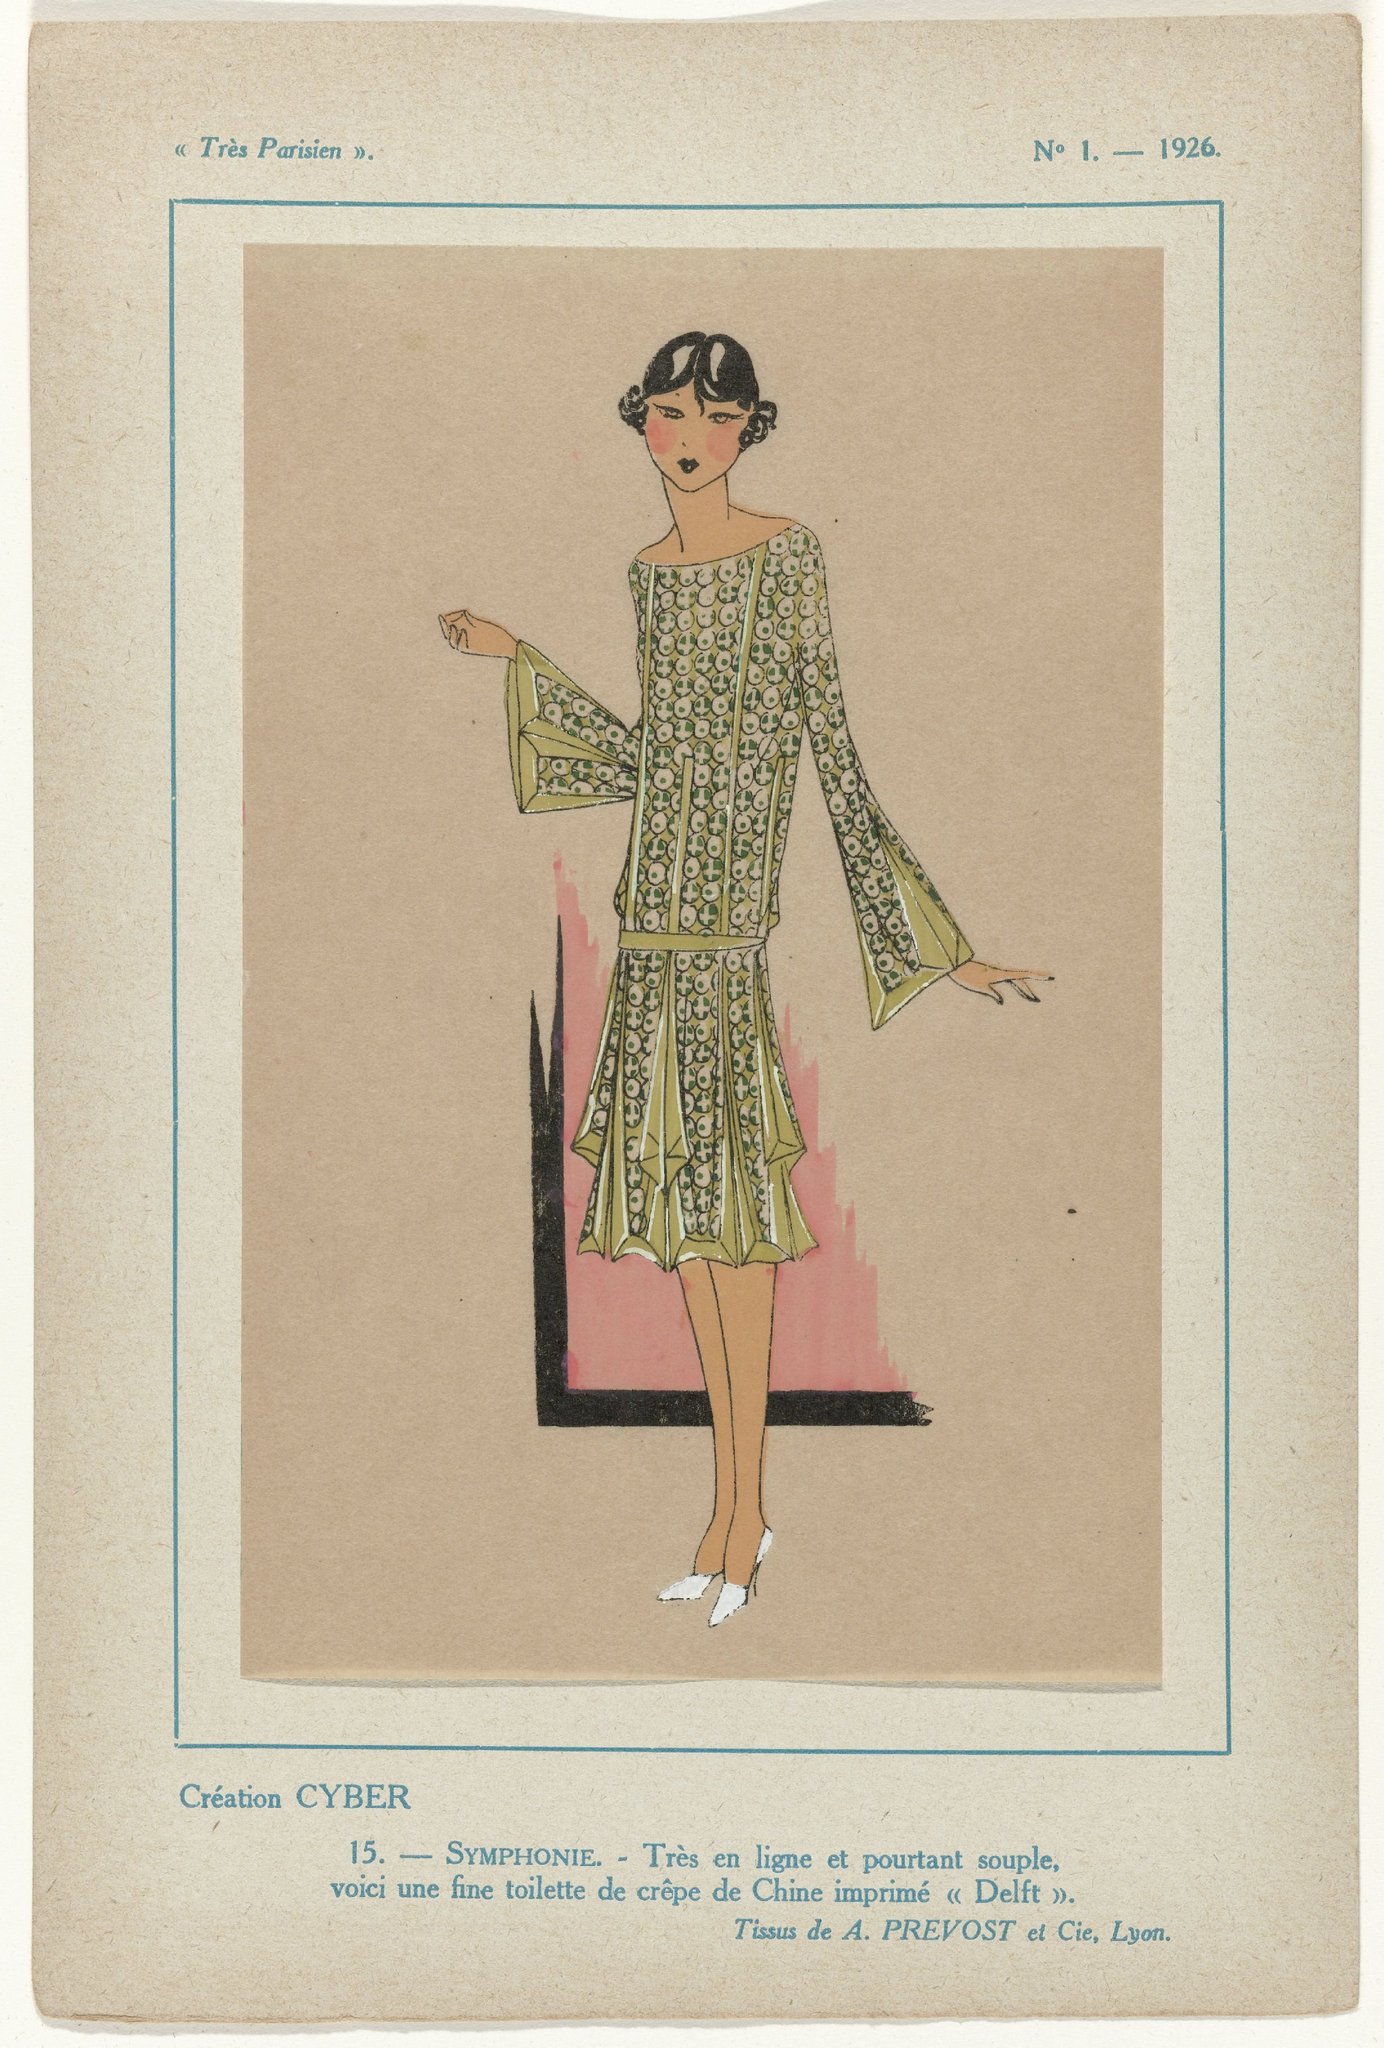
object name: fashion print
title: Très Parisien, 1926, No. 1, Pl. 15: Création CYBER - SYMPHONIE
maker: g-p. joumard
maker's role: publisher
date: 1926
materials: paper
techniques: hand coloring, letterpress printing, lithography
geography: paris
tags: dress, gown: day dress (+ women's clothes), fashion plates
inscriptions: caption: ‘Tissus de A. Prévost et Cie, Lyon’, caption: ‘SYMPHONIE. - Très en ligne et pourtant souple, voici une fine toilette de crêpe de Chine imprimée < Delft >’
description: Japon van Crêpe de Chine, bedruk met patroon . Stof van A. Prévost, Lyon. Prent uit het modetijdschrift Très Parisien... La Mode, Le Chic, L'Élegance (1920-1936)